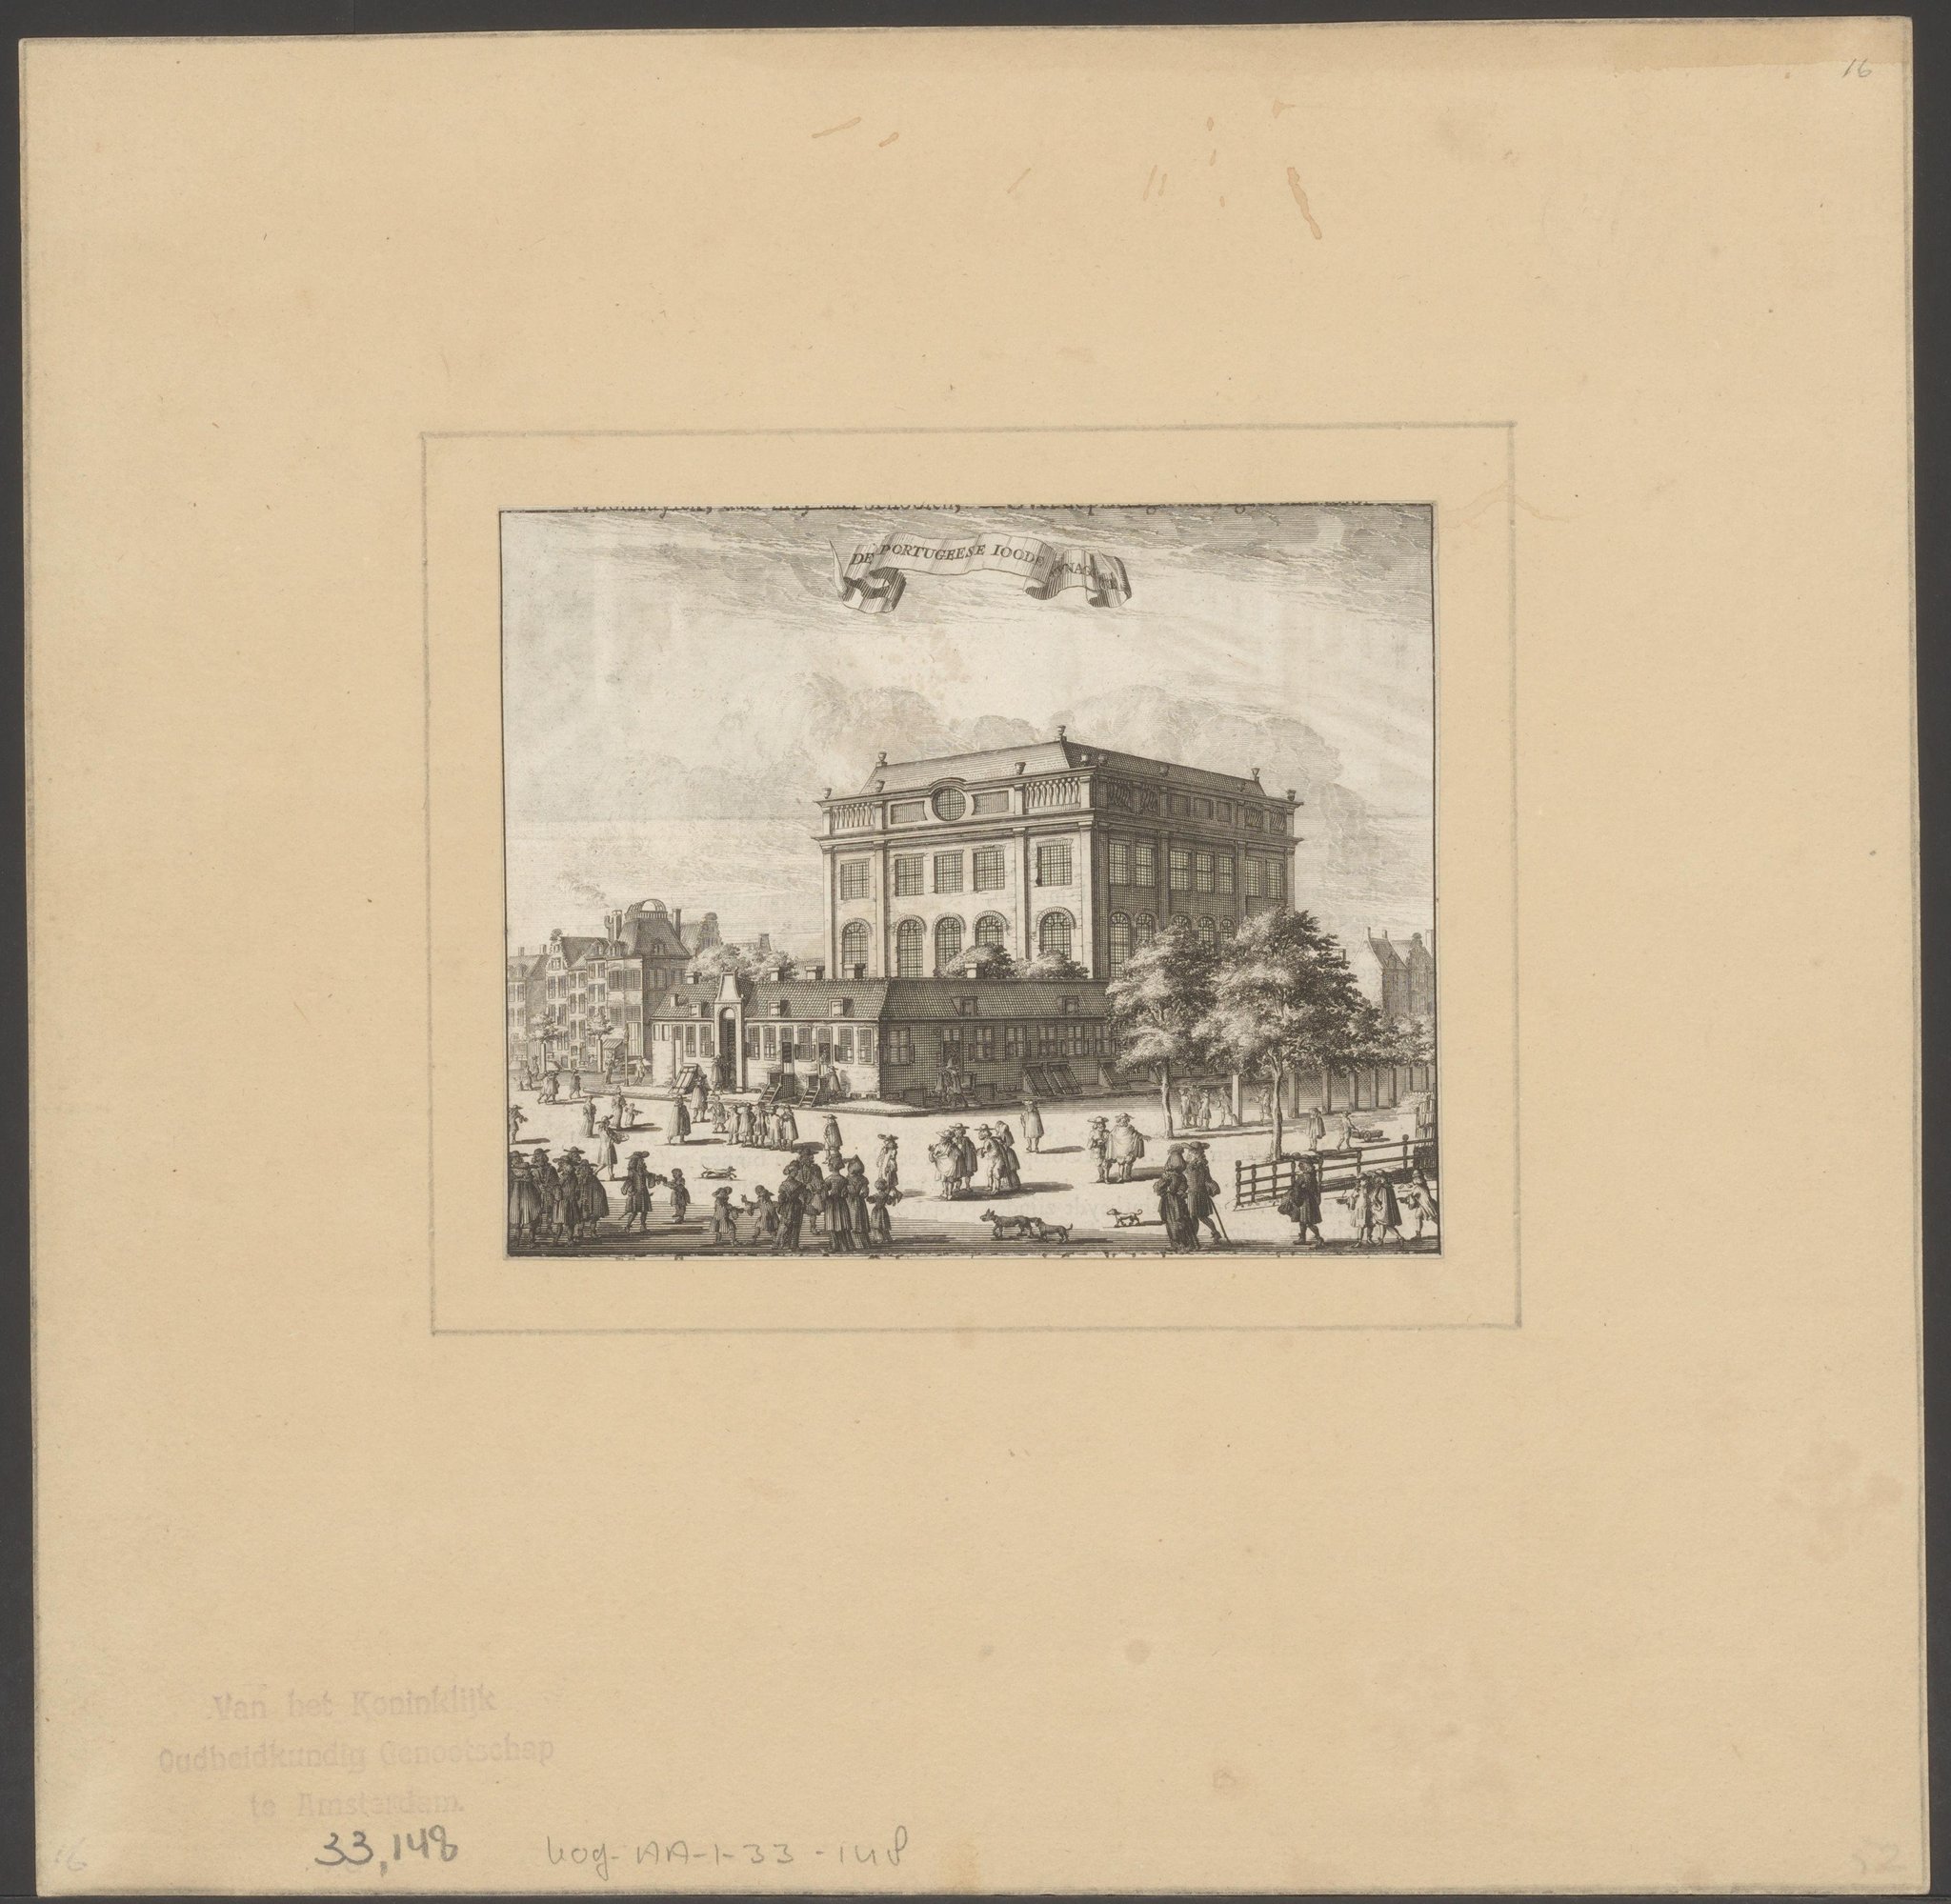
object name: print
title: De Portugeese Ioode Synagoge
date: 1693-1694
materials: paper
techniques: engraving, etching, letterpress printing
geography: northern netherlands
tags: the synagogue (as building and place of worship ~ jewish religion), street (+ city(-scape) with figures, staffage)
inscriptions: collector's mark: ‘ Van het Koninklijk Oudheidkundig Genootschap te Amsterdam. ’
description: Prent uit: Commelin, Casparus. Beschryvinge van Amsterdam (…). Amsterdam: Abraham Wolfgang, Gillis Janssonius van Waesberge of Johannes Janssonius van Waesberge, Hendrick Boom of weduwe Dirk Boom, Abraham van Sanderen en Rembertus Goethals, 1693, dl. 1, p. 502. Of uit: Commelin, Casparus. Beschryvinge van Amsterdam (…). Amsterdam: weduwe Aart Dircksz. Oossaan, 1694, dl. 1, p. 502.